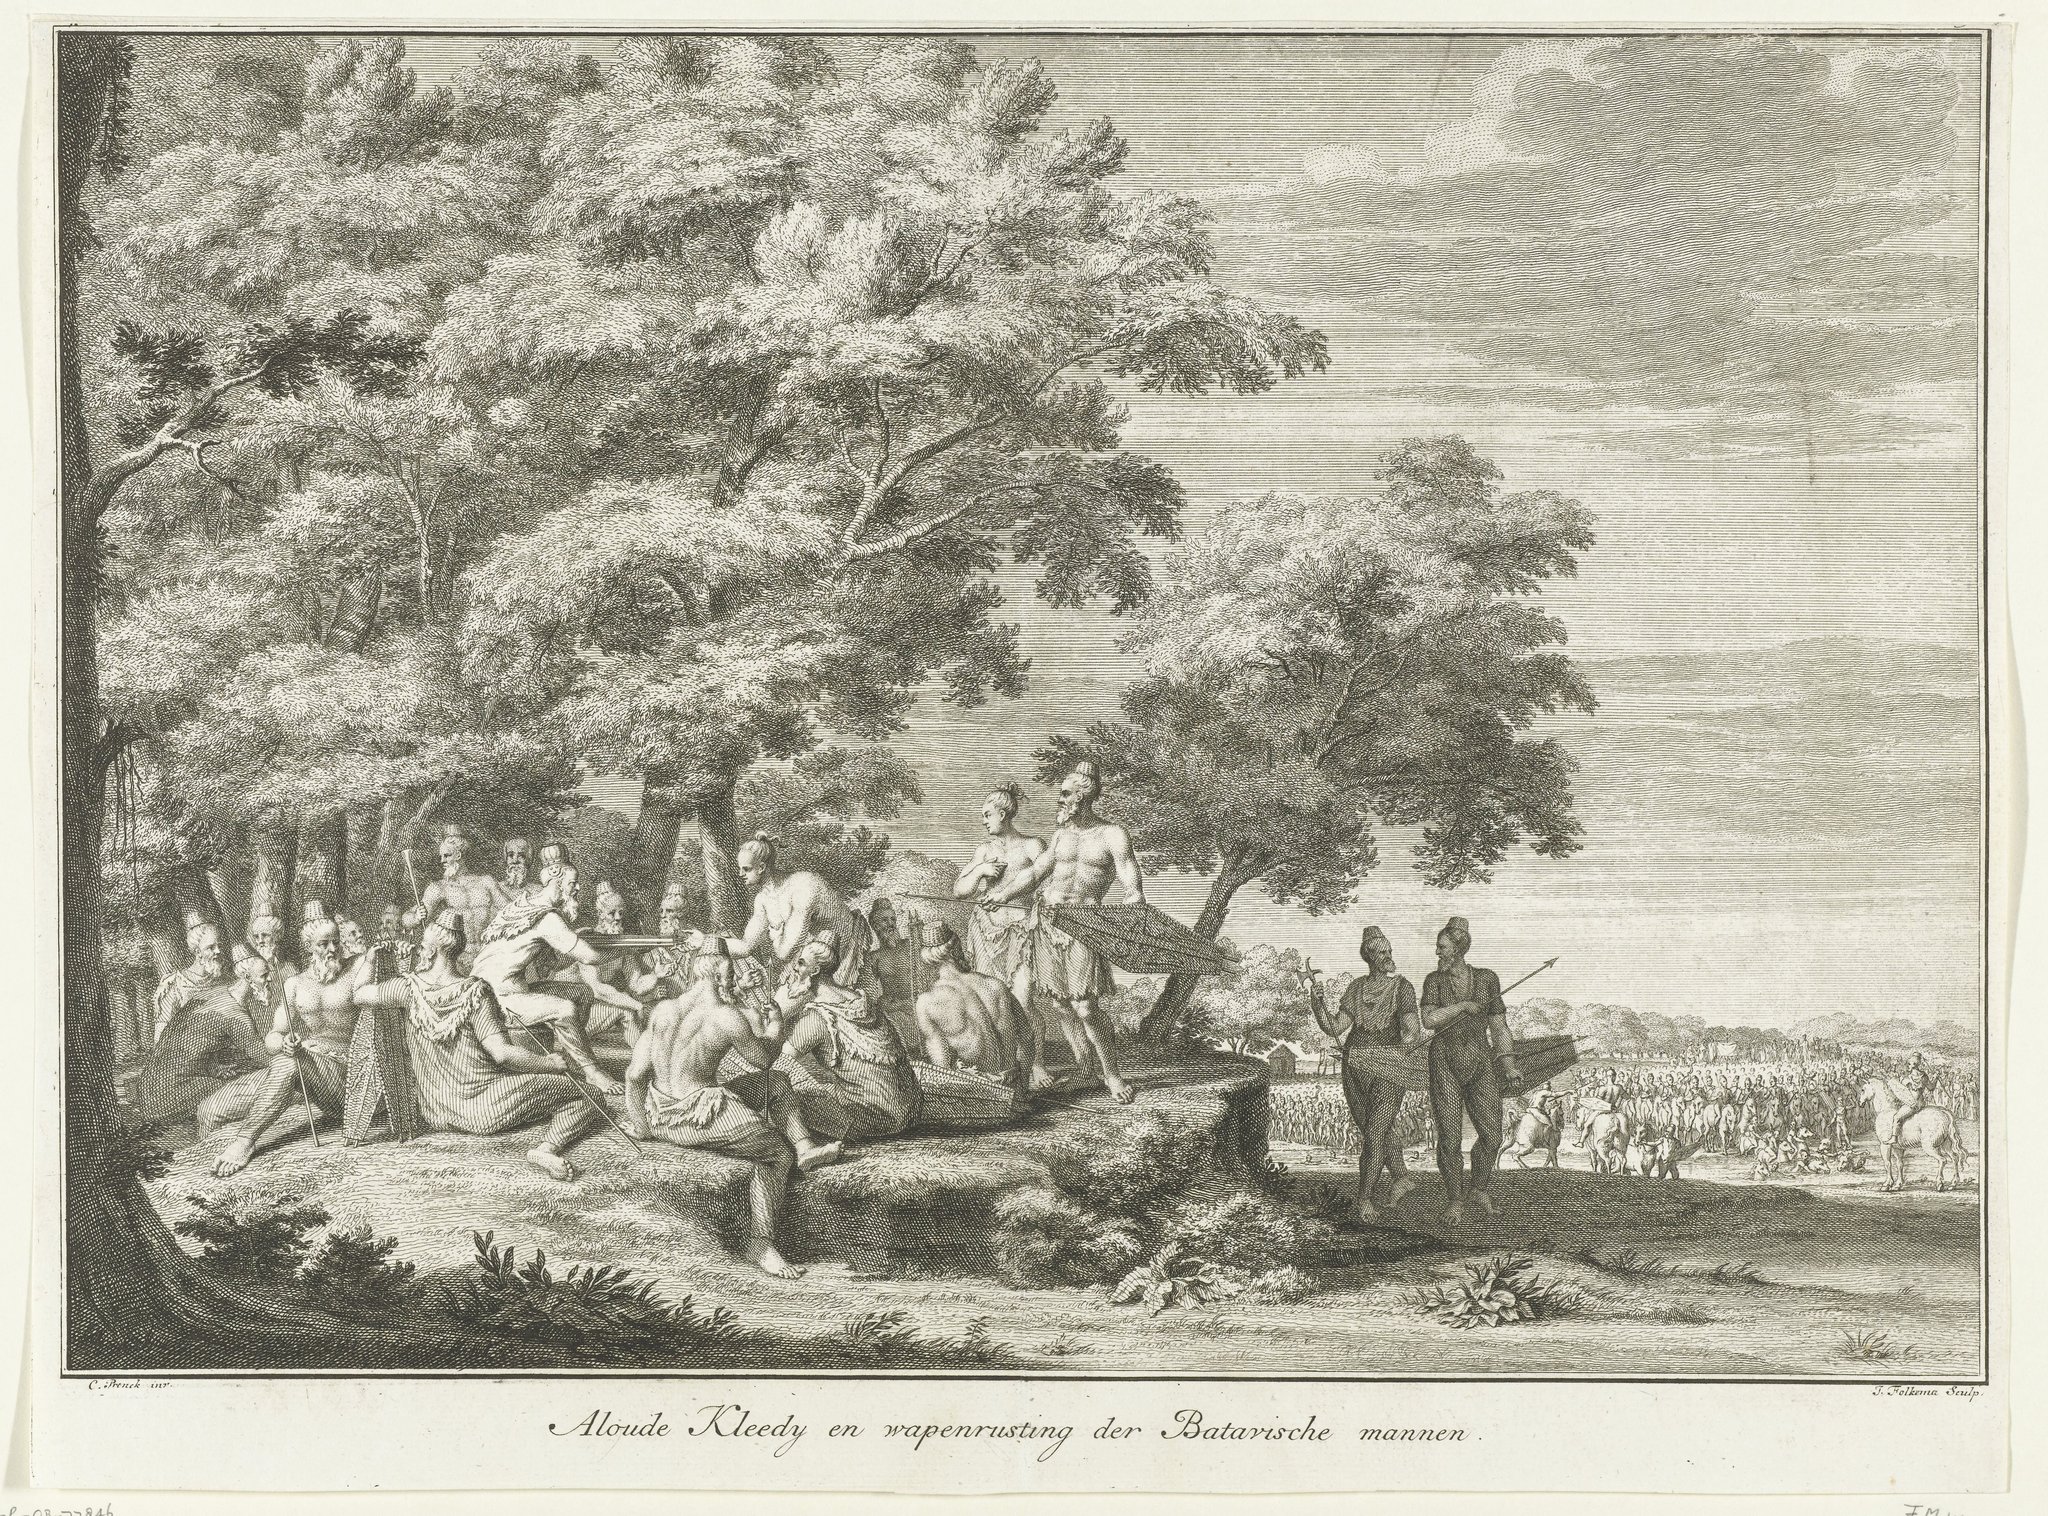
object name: history print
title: Aloude Kleedy en wapenrusting der Batavische mannen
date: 1732-1734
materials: paper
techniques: etching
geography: netherlands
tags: extinct, 'historical' peoples (with name), netherlands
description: Illustratie voor: Gerard van Loons Aloude Hollandsche histori, Pieter de Hondt, ’s-Gravenhage 1734.